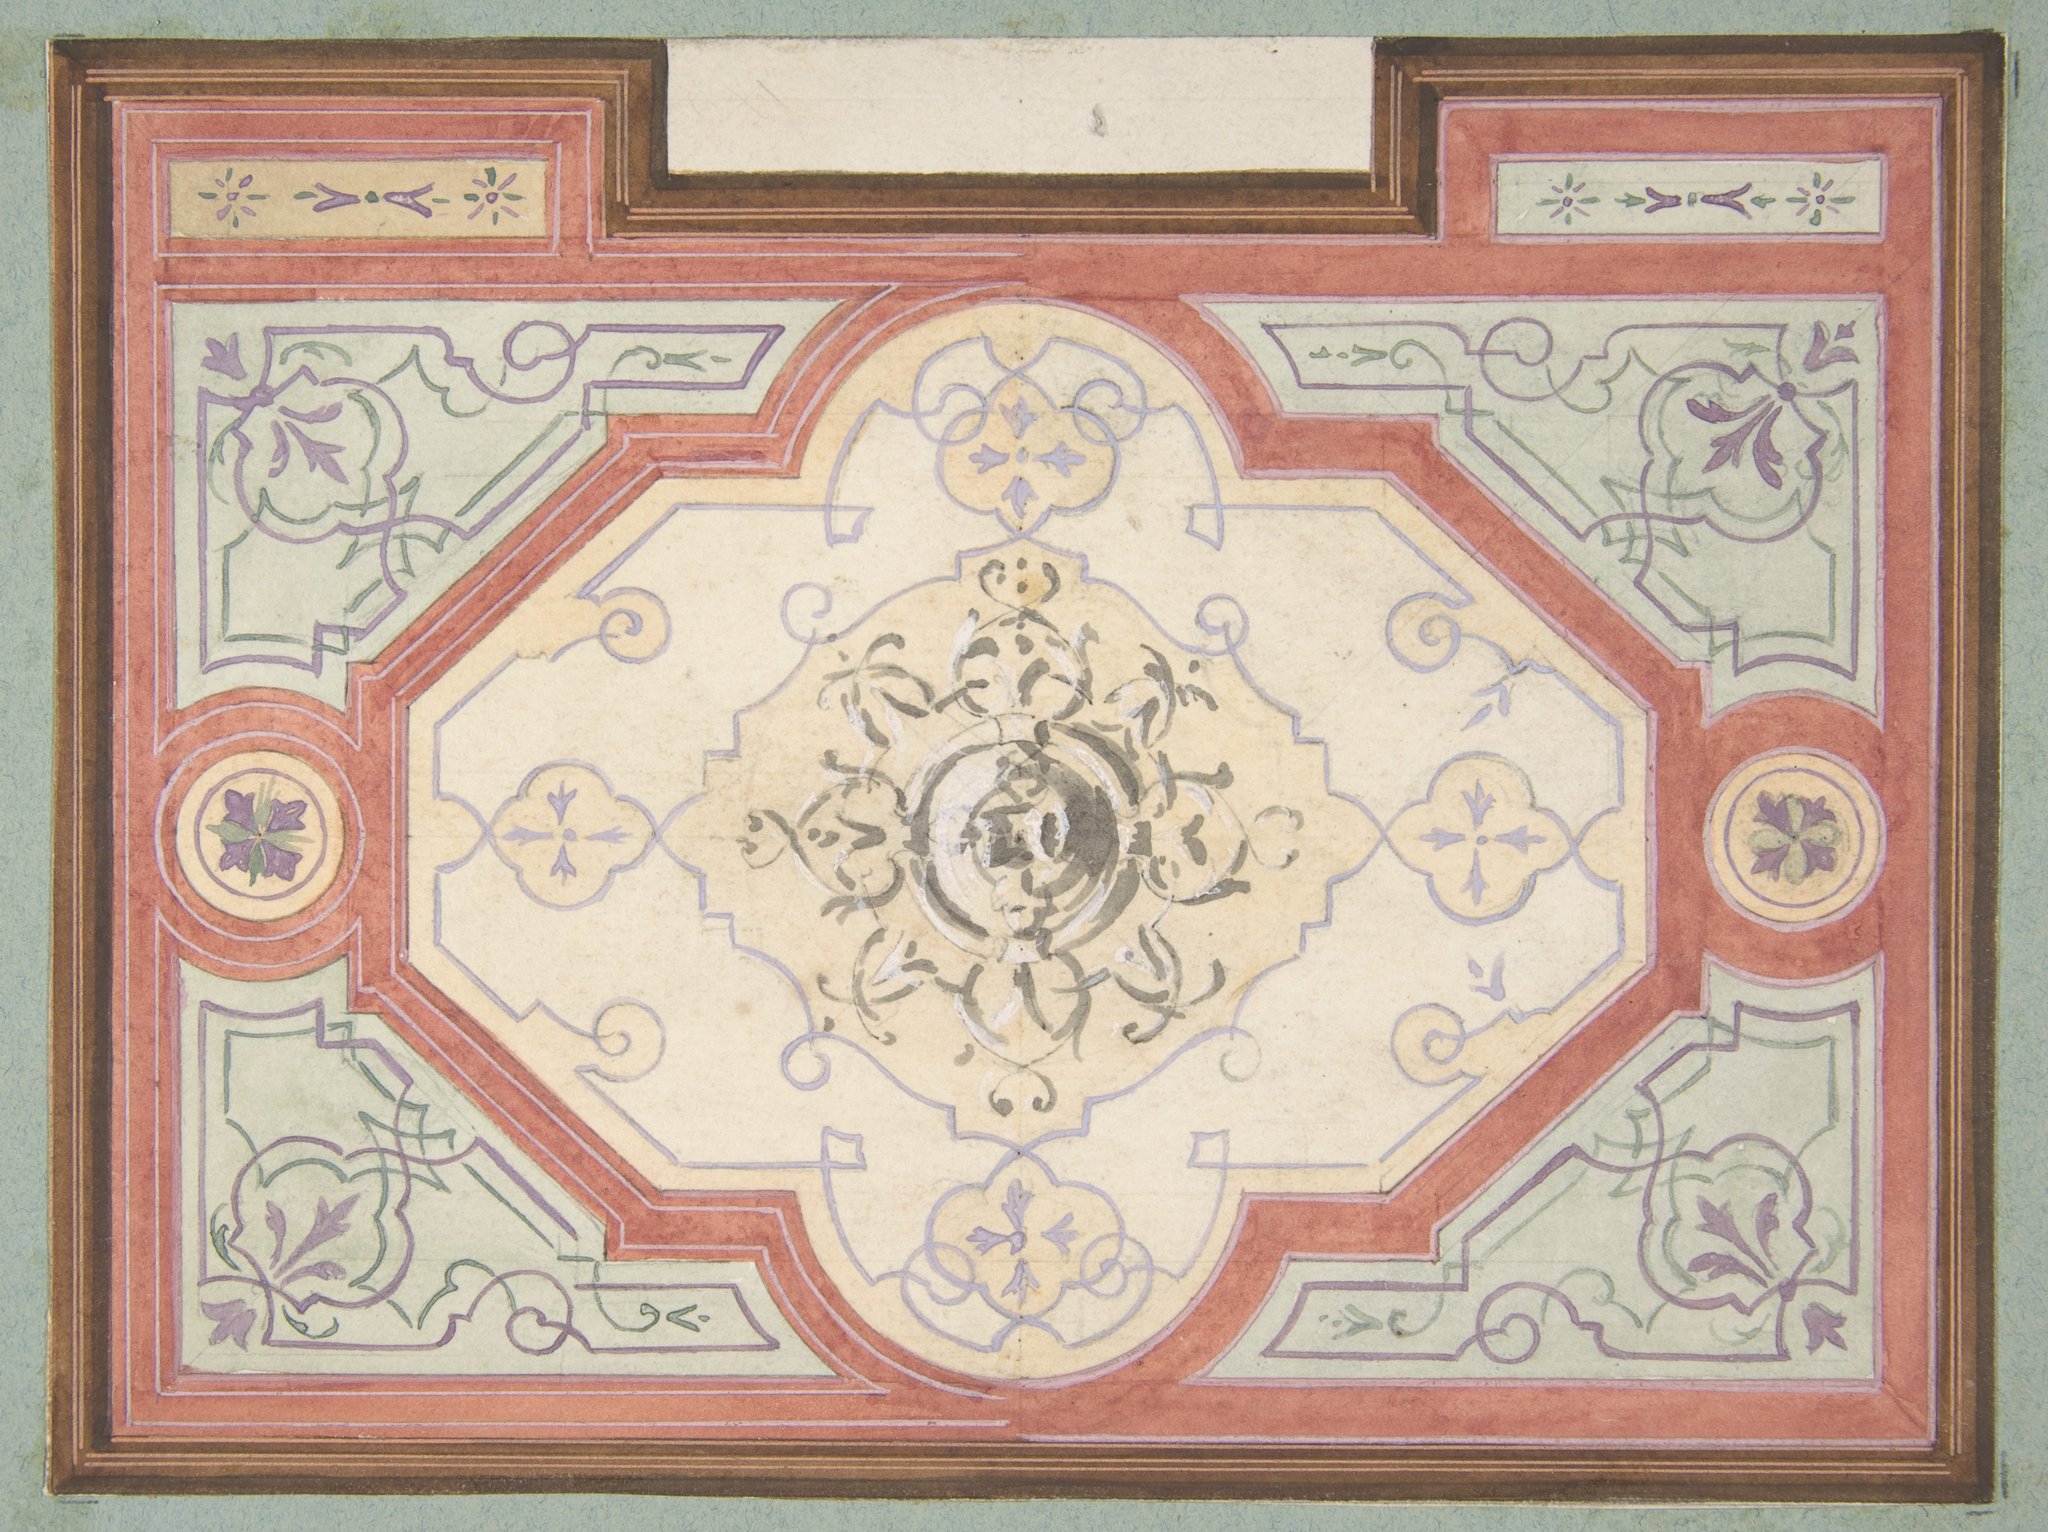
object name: drawing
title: Design for the decoration of a ceiling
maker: jules-edmond-charles lachaise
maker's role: artist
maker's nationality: french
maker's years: 1897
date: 1830-1897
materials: gouache, graphite, paper, watercolor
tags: ceilings